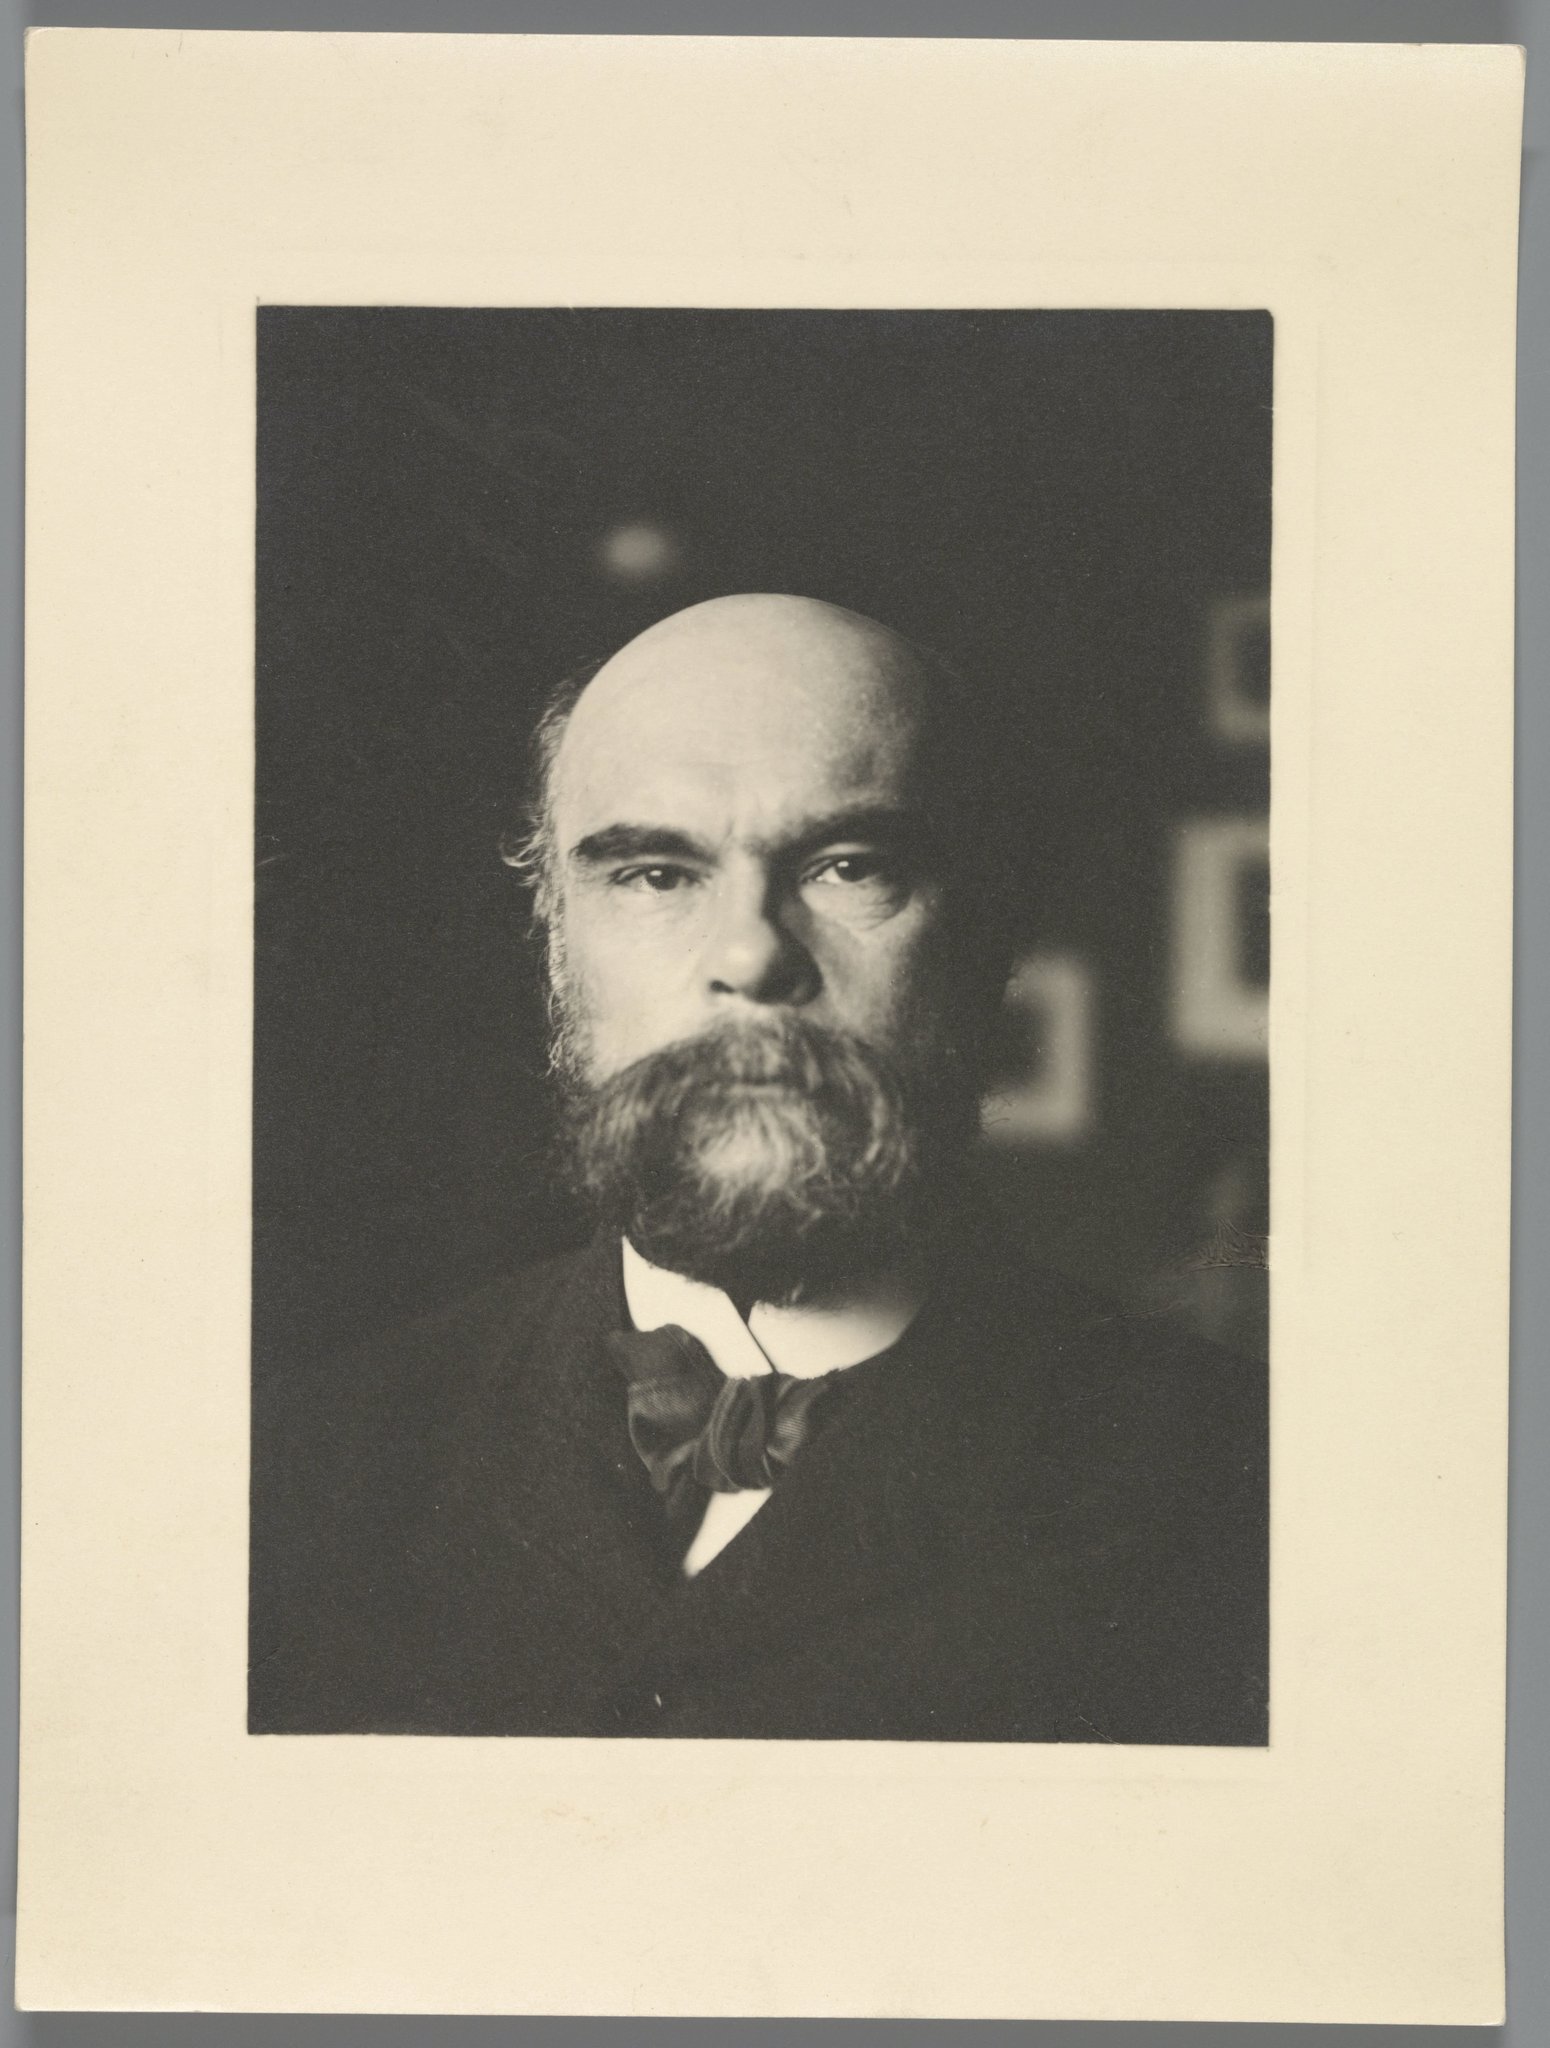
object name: photograph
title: Reproductie naar een foto van Willem Witsen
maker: Anonymous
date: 1860-1915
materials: paper, photographic support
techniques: gelatin silver print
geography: netherlands